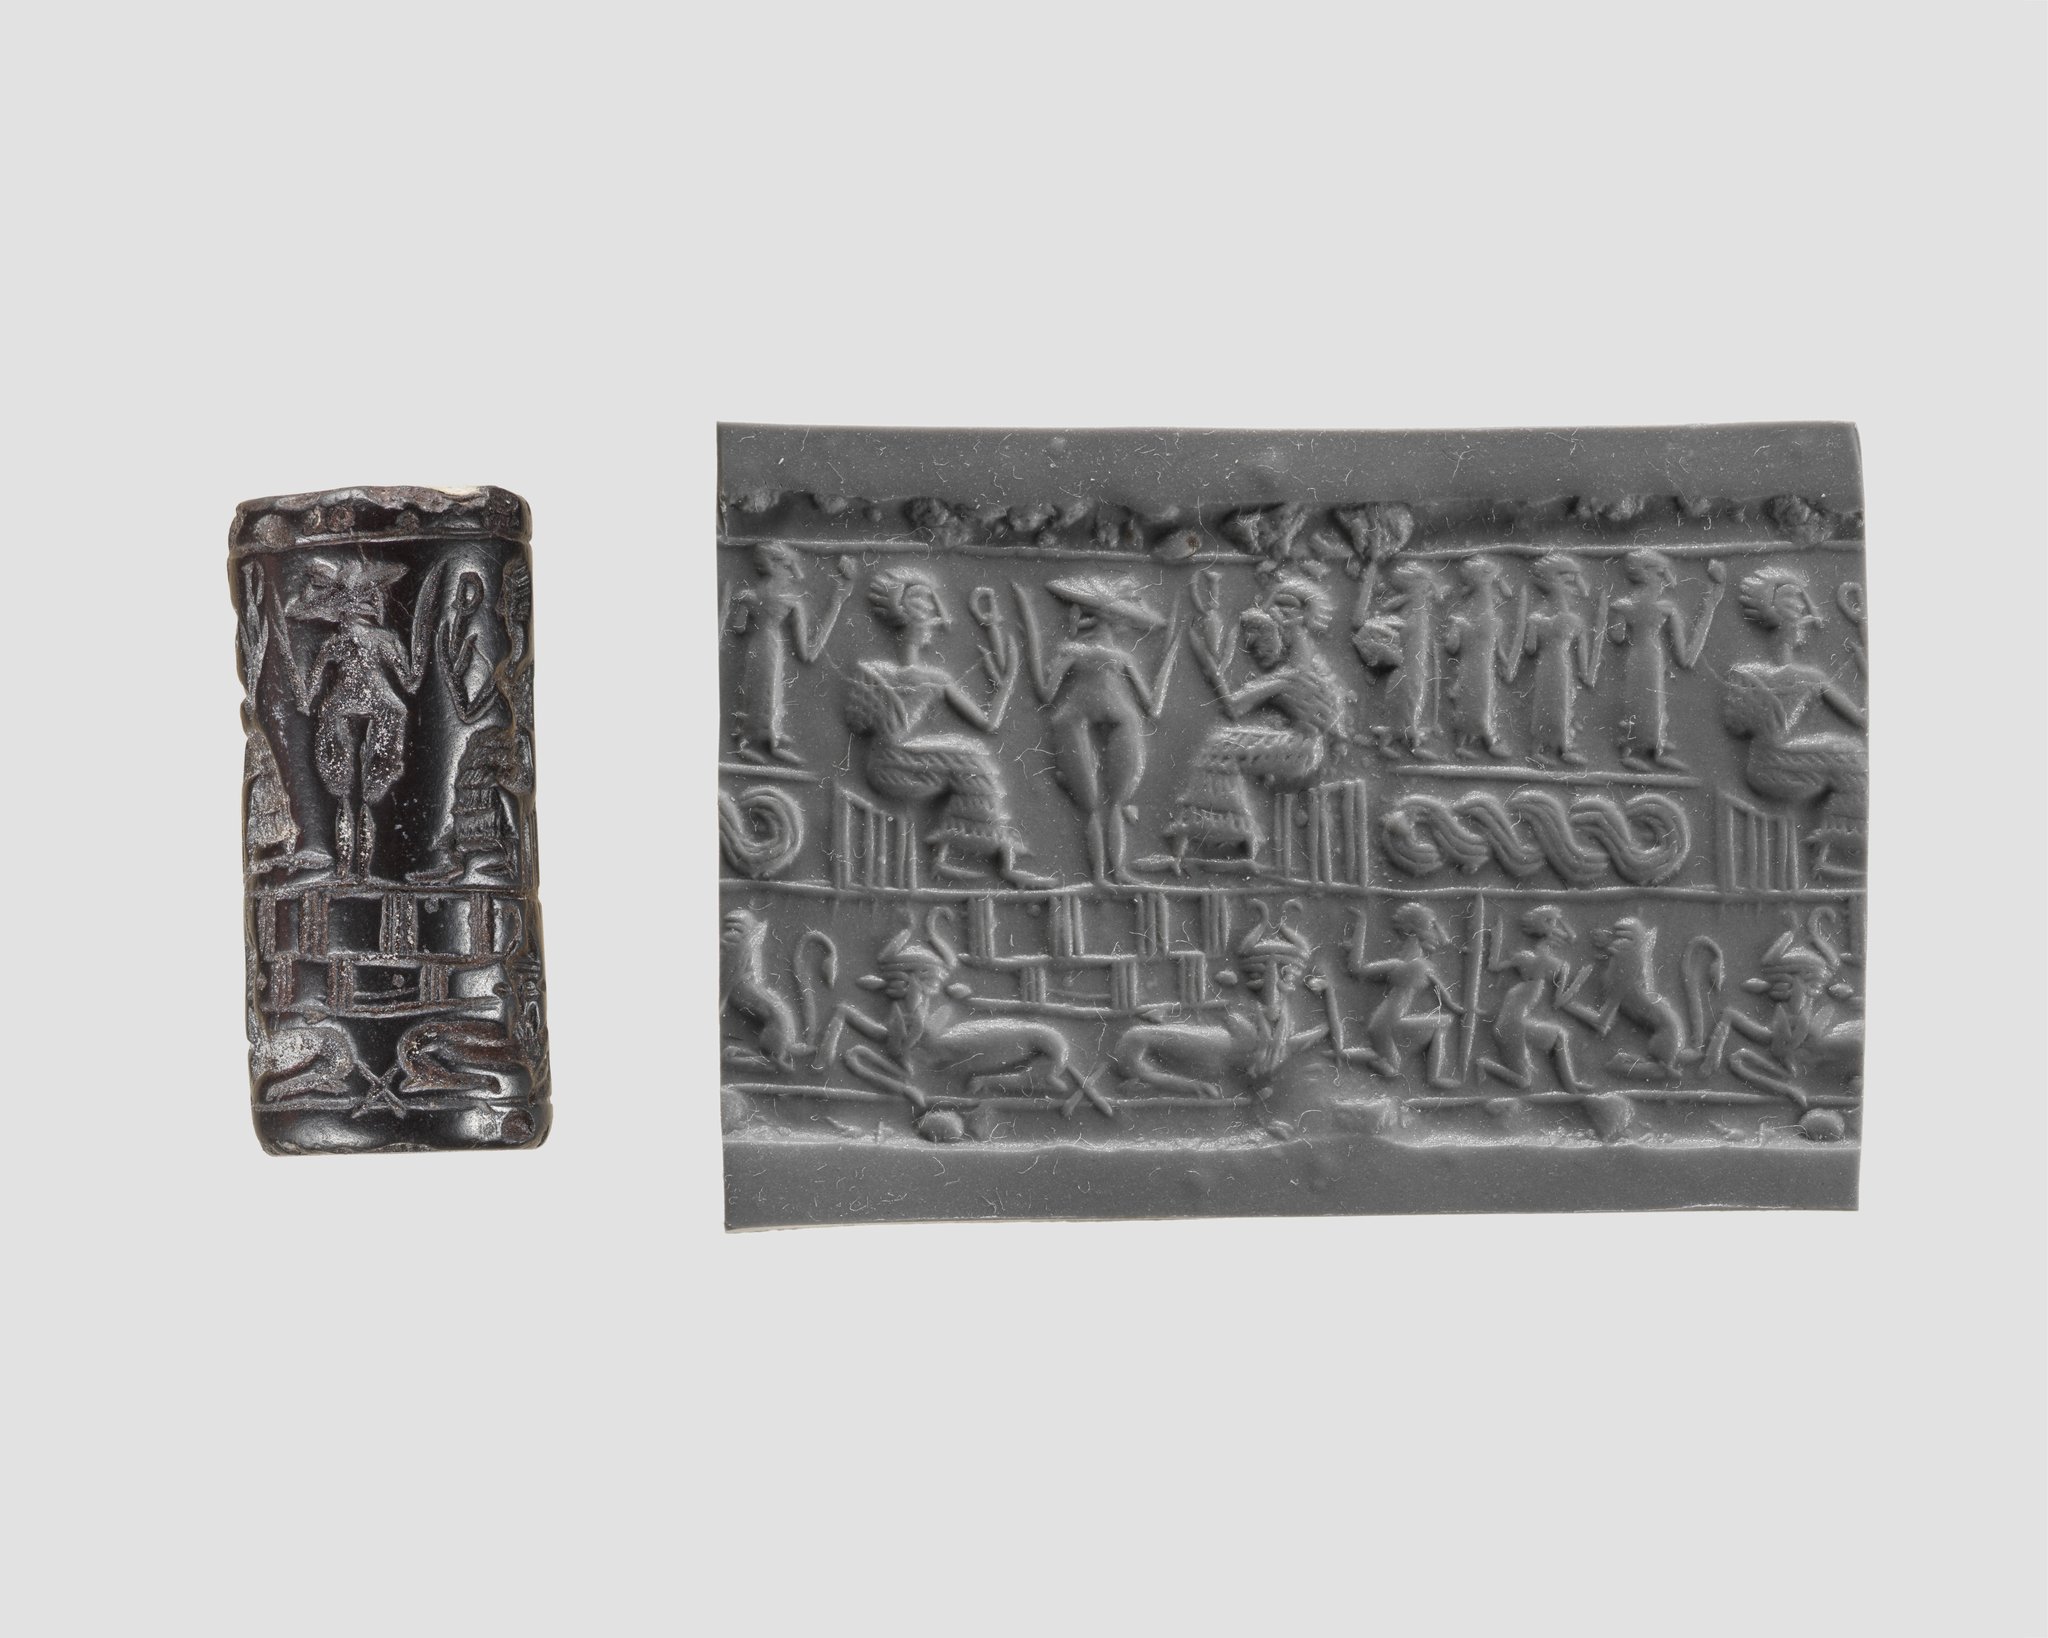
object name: cylinder seal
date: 1820-1730 BCE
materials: mineral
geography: syria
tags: animals